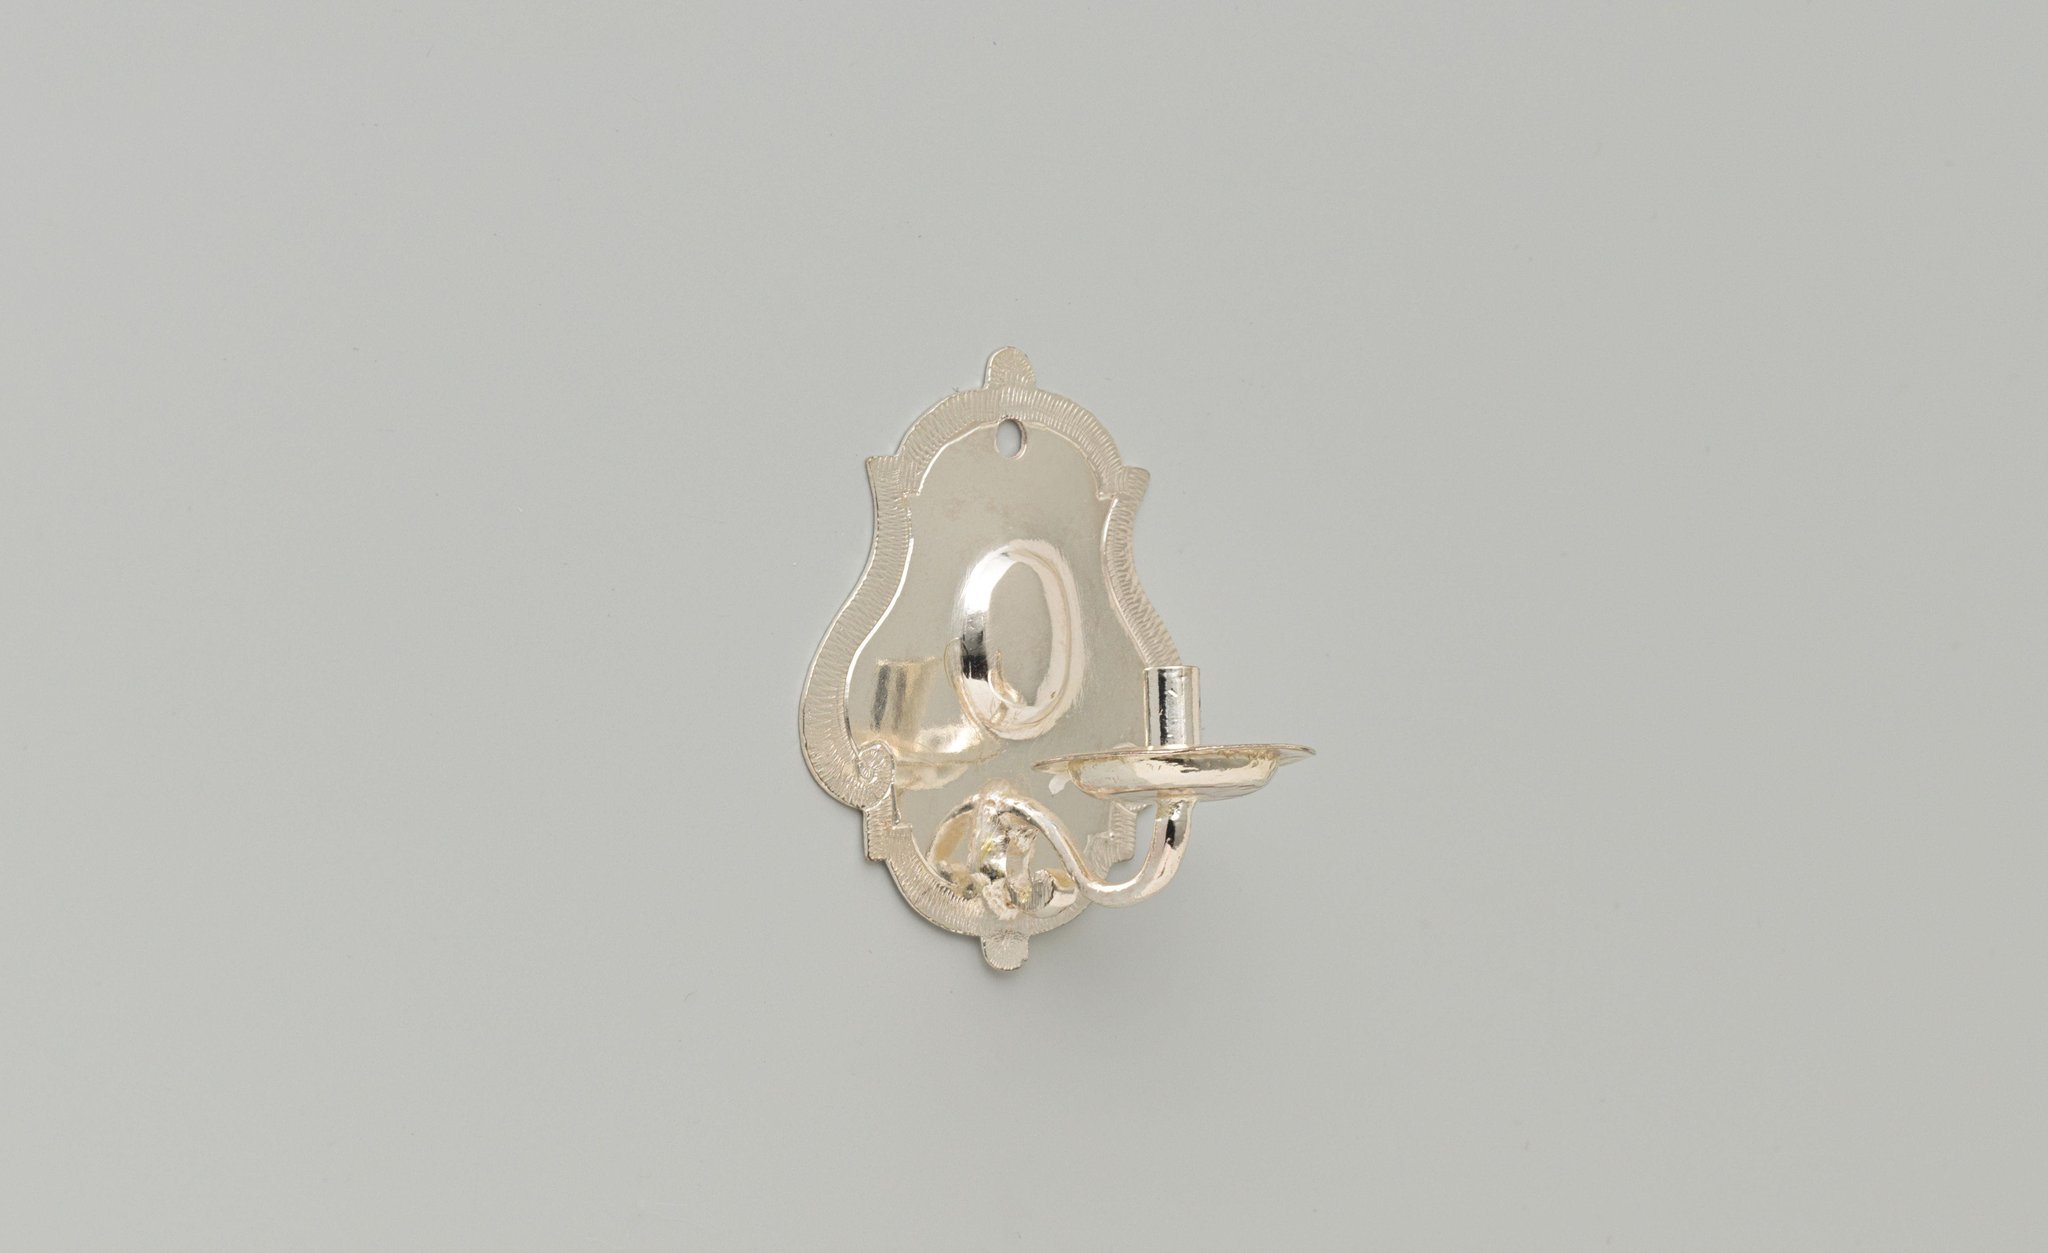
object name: sconce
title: Wandarm van zilver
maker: willem van strant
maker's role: silversmith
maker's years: 1682-1742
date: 1727-1742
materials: silver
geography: amsterdam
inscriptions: maker's mark: ‘VS (Citroen, nr. 899)’, town mark: ‘kleine stadskeur Amsterdam’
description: Wandarm van zilver, schildvormige wandplaat met centraal ovaal, met in en uitzwenkende omtrek met getrembleerde rand. S-vormige arm met gladde ronde kaarshouder en vetvanger. Hierbij hoort een tweede exemplaar (A).